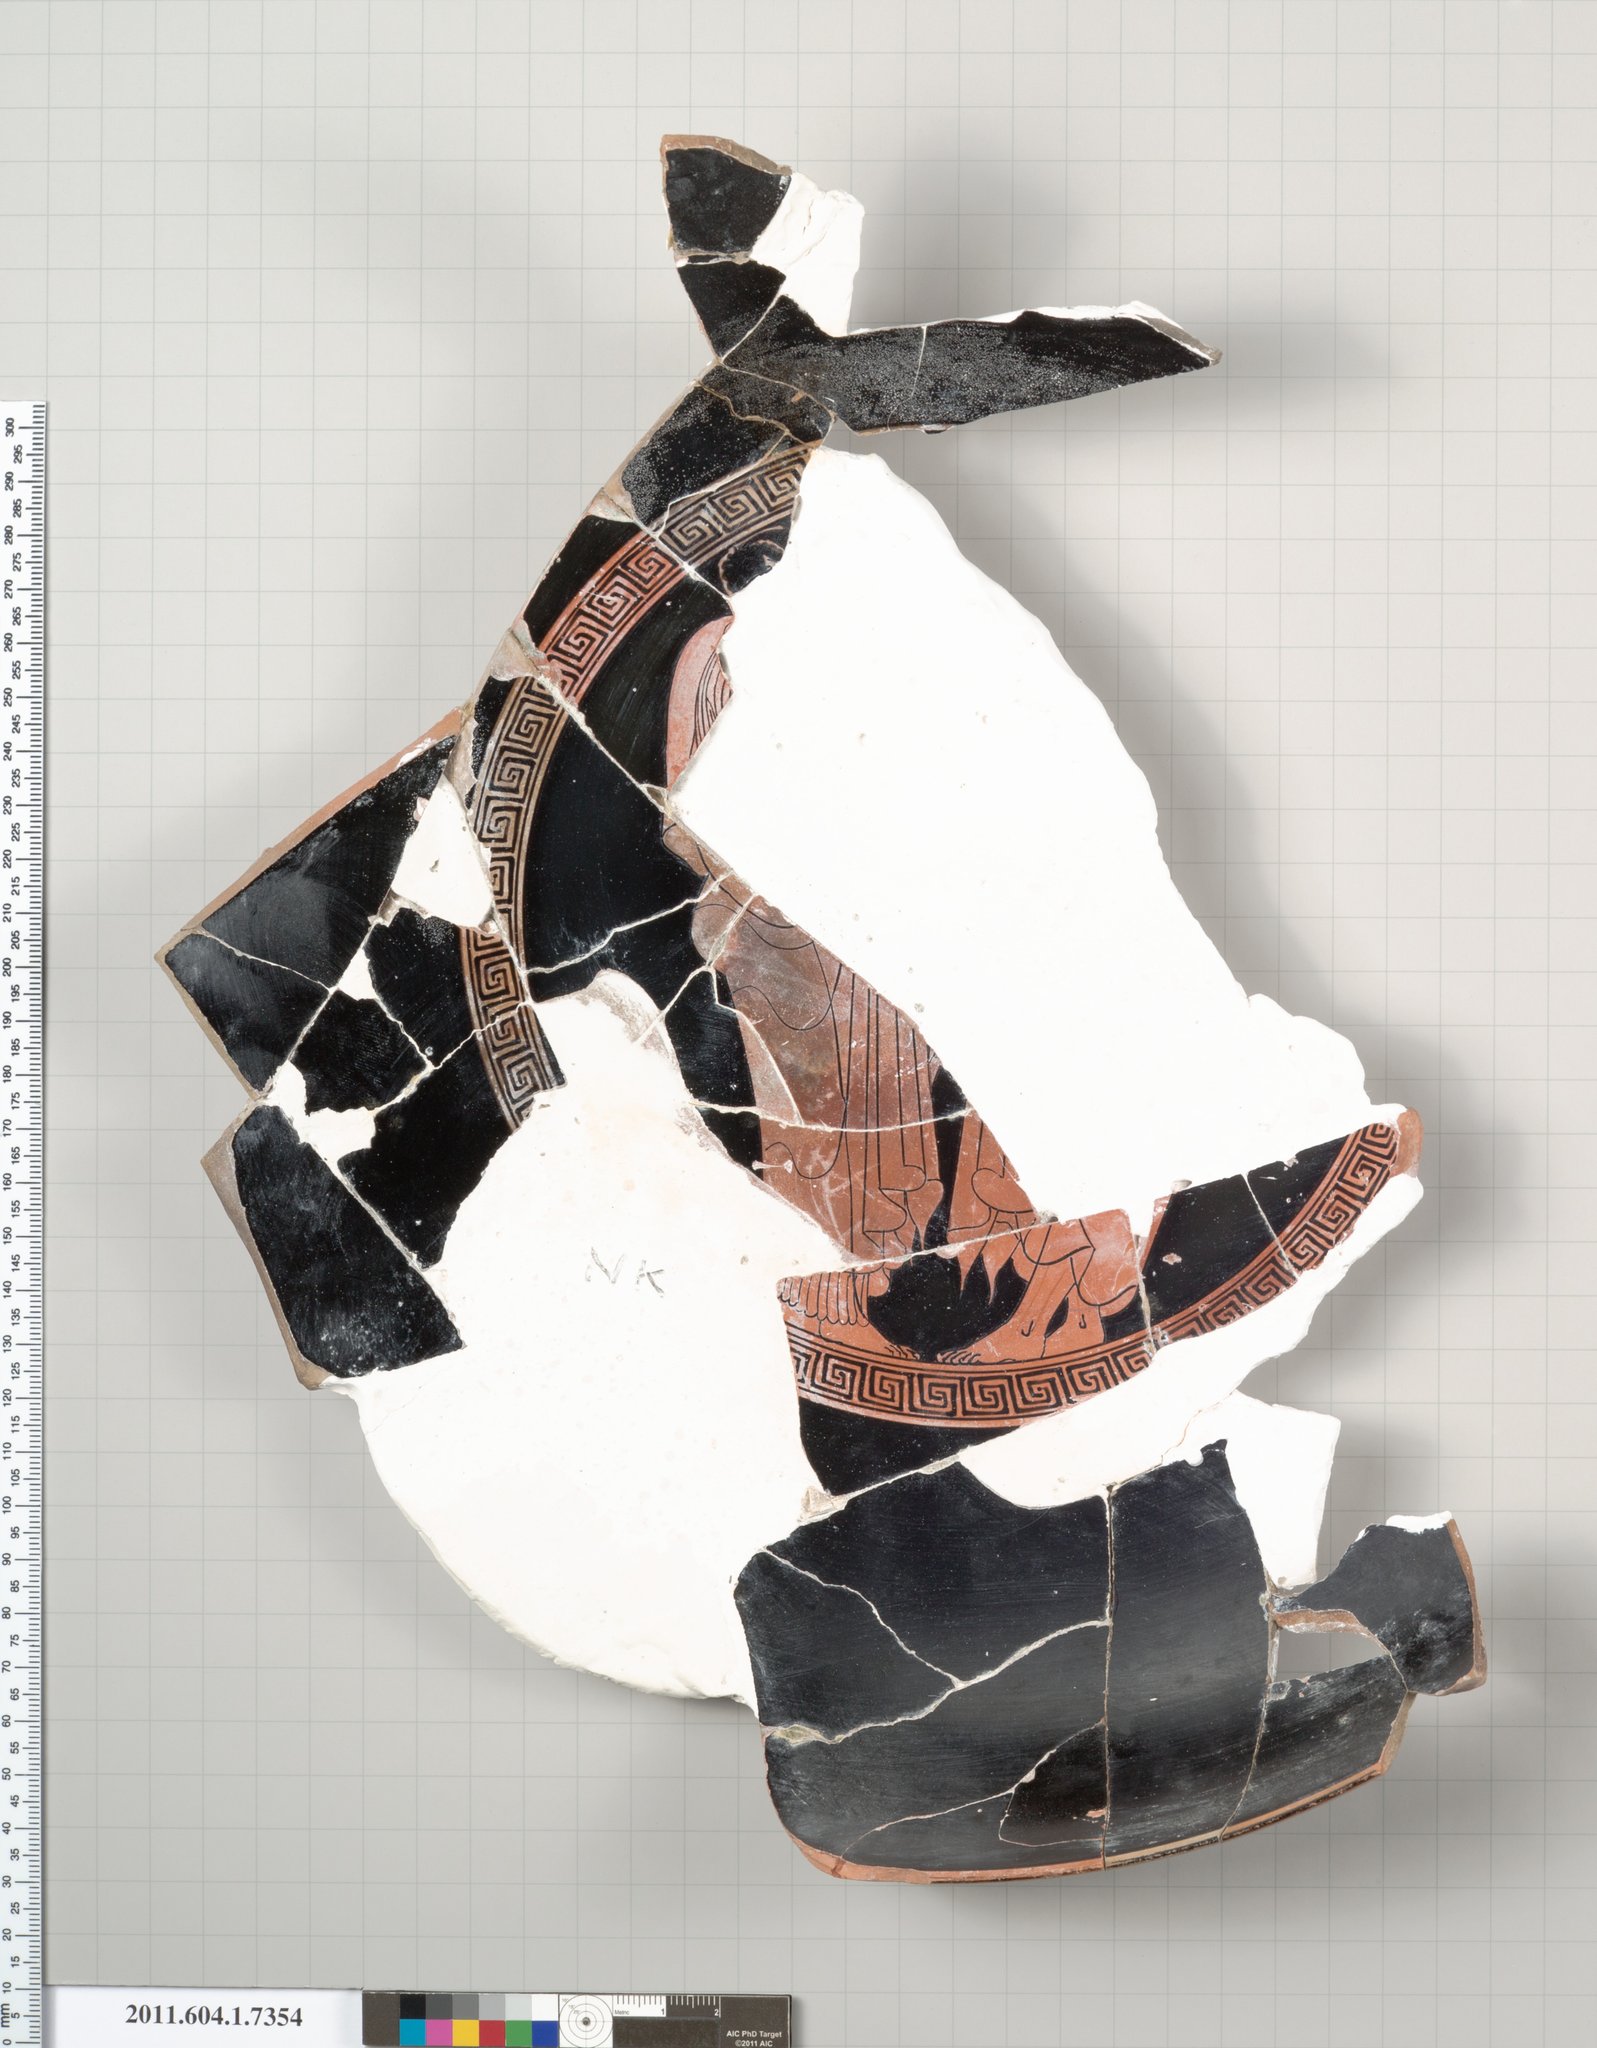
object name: kylix fragment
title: Terracotta fragment of a kylix (drinking cup)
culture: greek, attic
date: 500-480 BCE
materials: terracotta